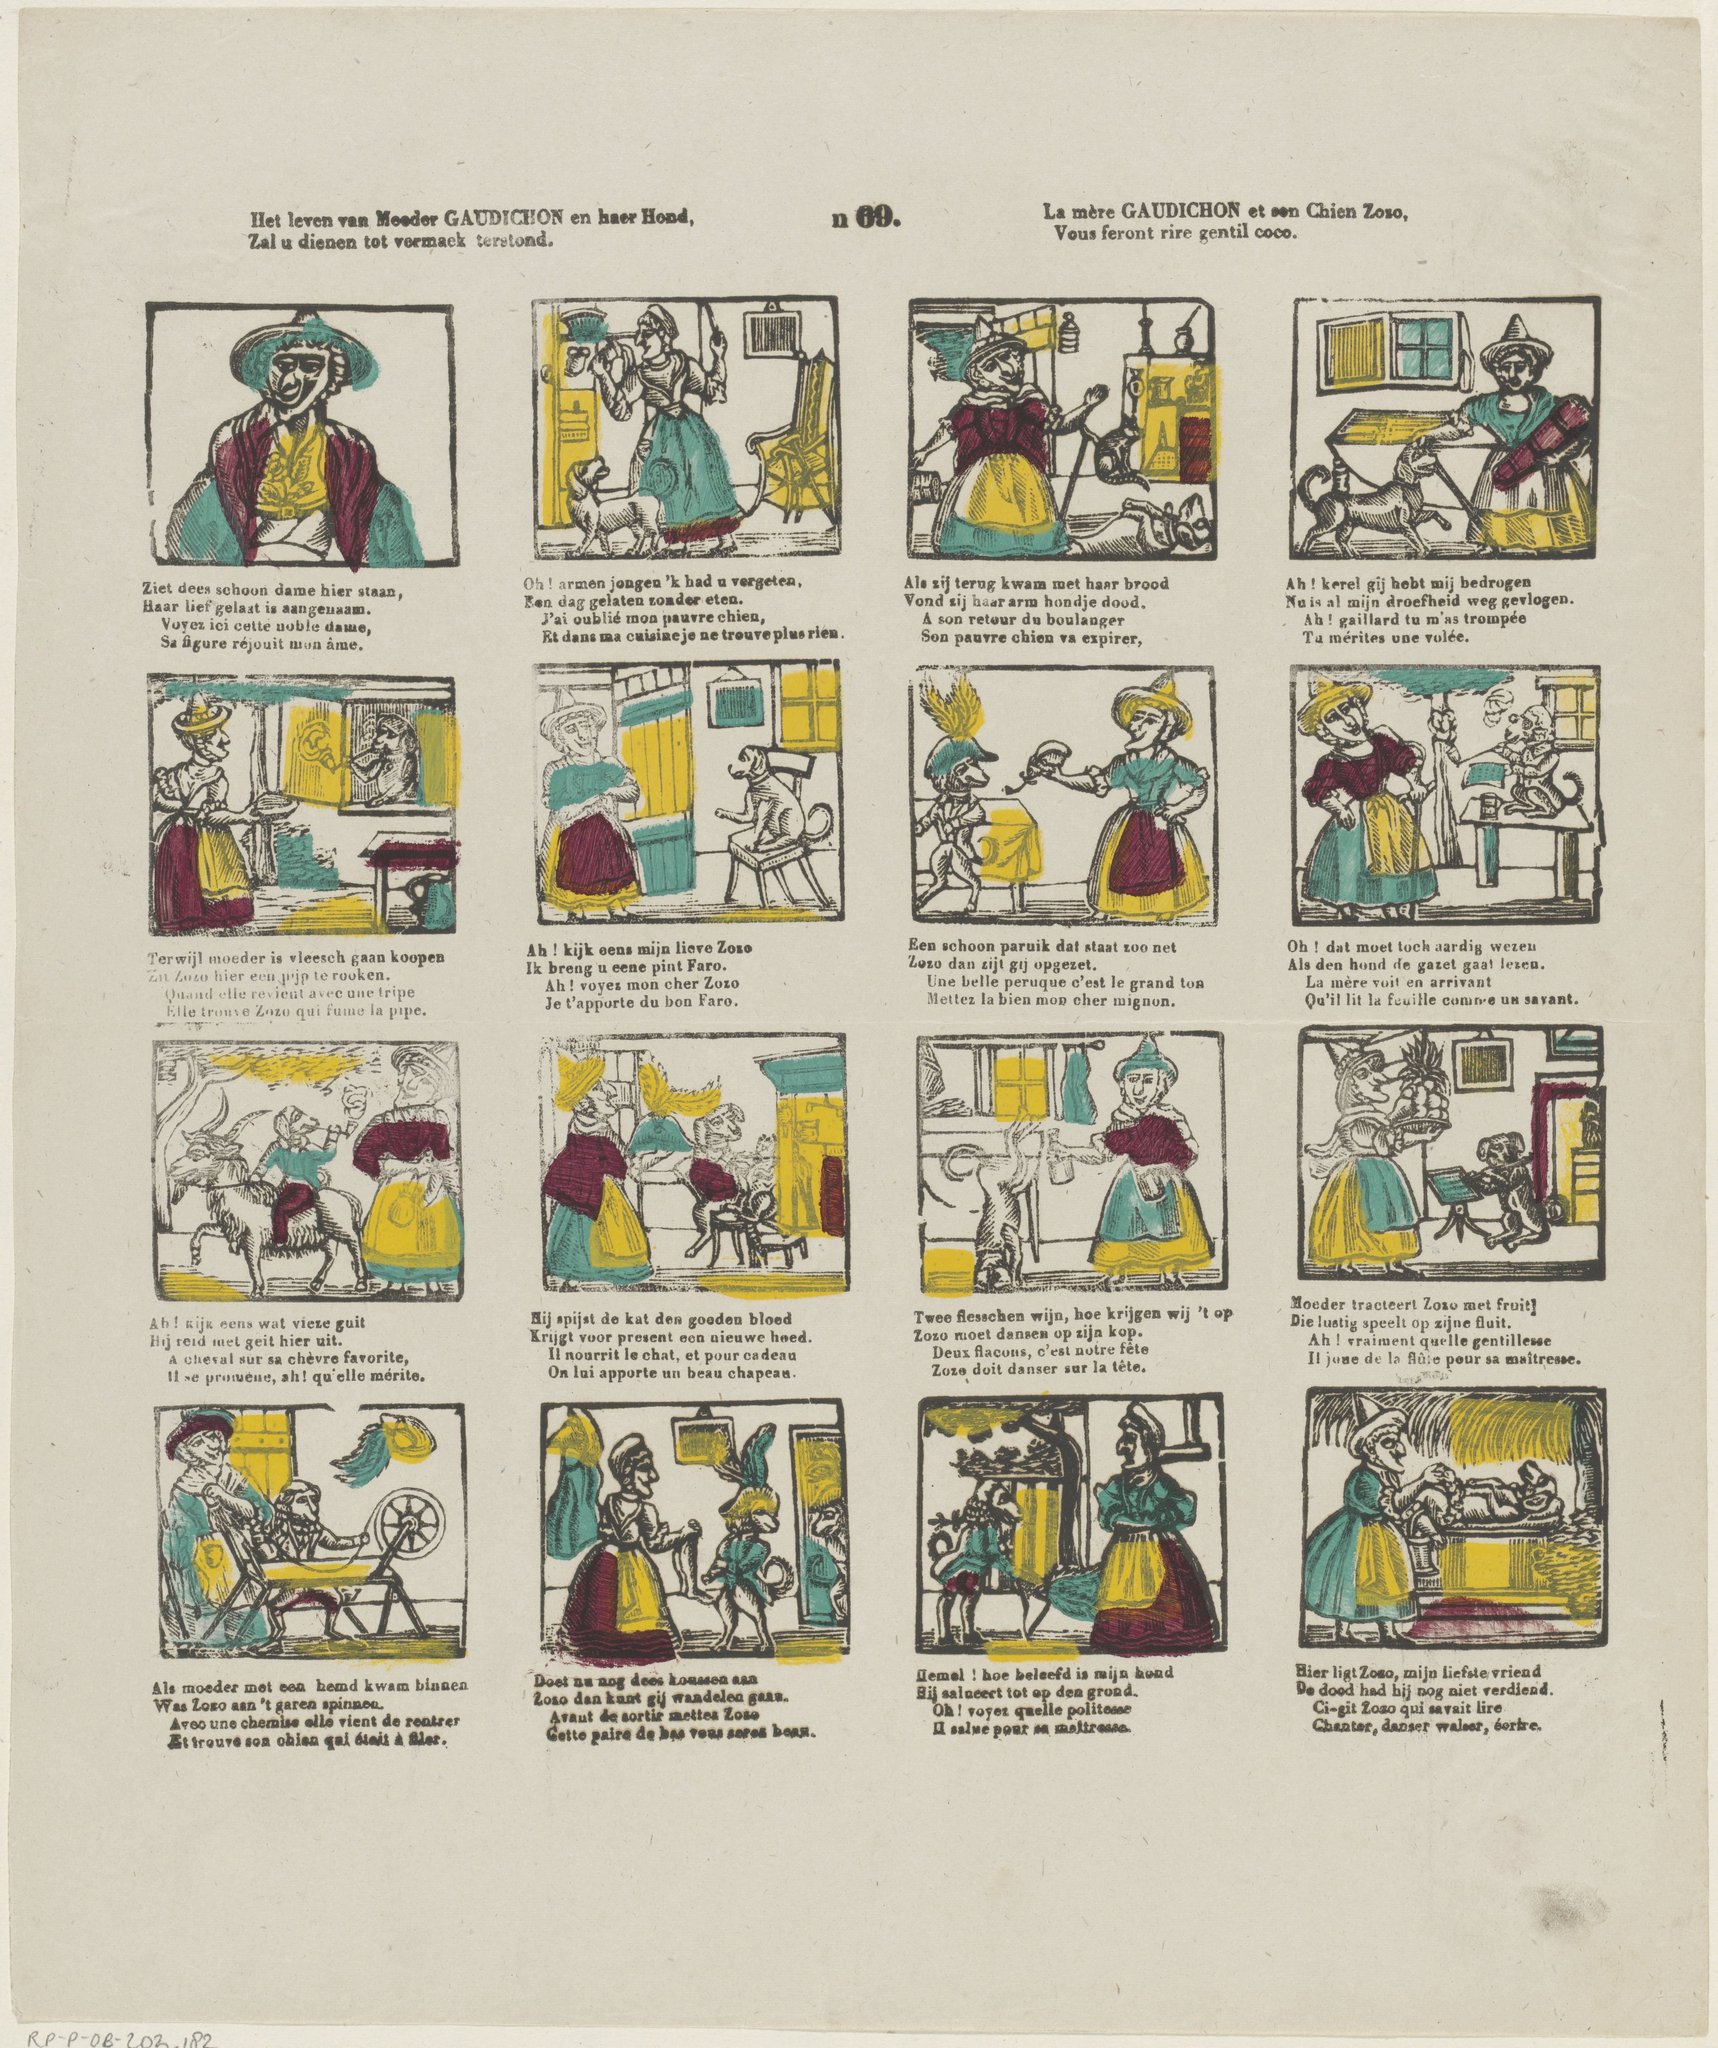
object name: popular print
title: Het leven van moeder Gaudichon en haer hond, / Zal u dienen tot vermaek terstond / La mère Gaudichon et son chien Zozo, / Vous seront rire gentil coco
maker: Anonymous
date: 1856-1900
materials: paper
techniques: colour, letterpress printing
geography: turnhout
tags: 'mundus inversus', the reversed world, the topsy-turvy world, 'le monde bestourné', dog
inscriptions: collector's mark: Lugt 2760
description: Blad met 16 voorstellingen uit het leven van juffrouw Gaudichon en haar hond. De hond kan allerlei kunstjes, waaronder op zijn kop staan, de pijp roken, op de fluit spelen, spinnen, gekleed gaan met schoenen, broek, jas en steek. Onder elke voorstelling een tweeregelig vers in het Nederlands en het Frans. Genummerd midden boven: n 69.